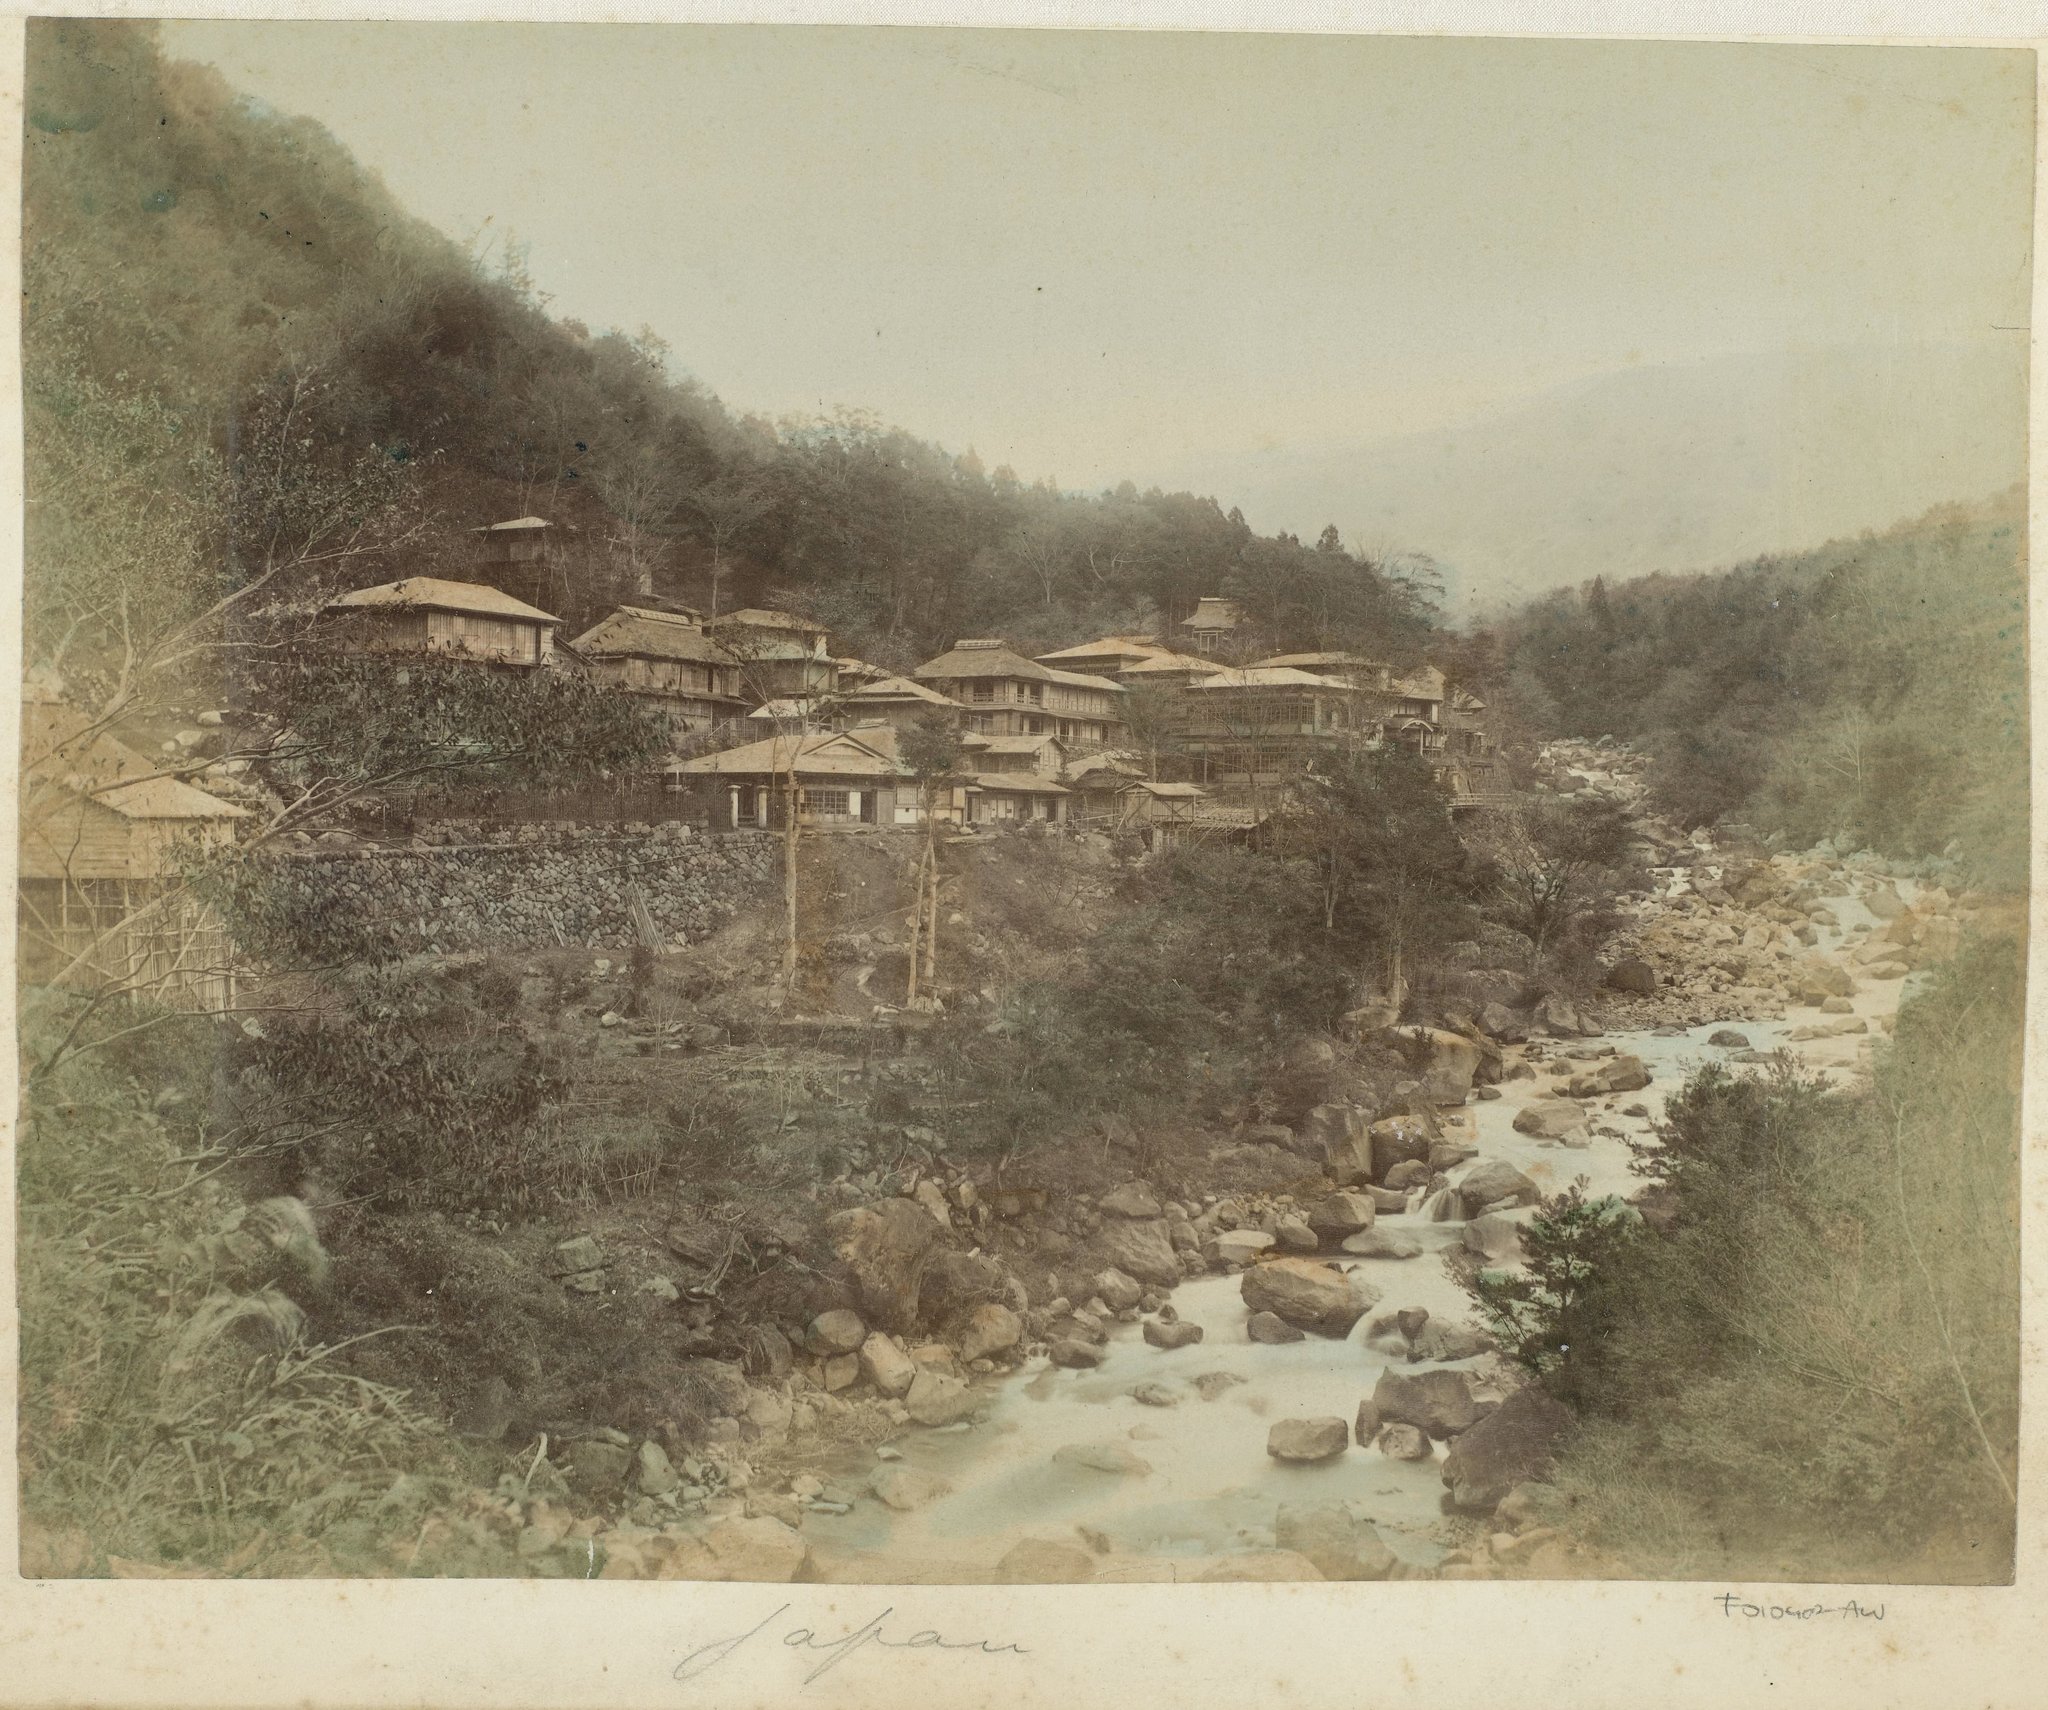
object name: photograph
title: Japan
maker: Anonymous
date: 1870-1895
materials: paper, photographic support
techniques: albumen print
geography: japan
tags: prospect of village, silhouette of village, brook, japan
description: Onderdeel van Reisalbum van H. Dunlop met foto's van bezienswaardigheden in Perzië, Schotland, Duitsland, Rusland, China en Canada.